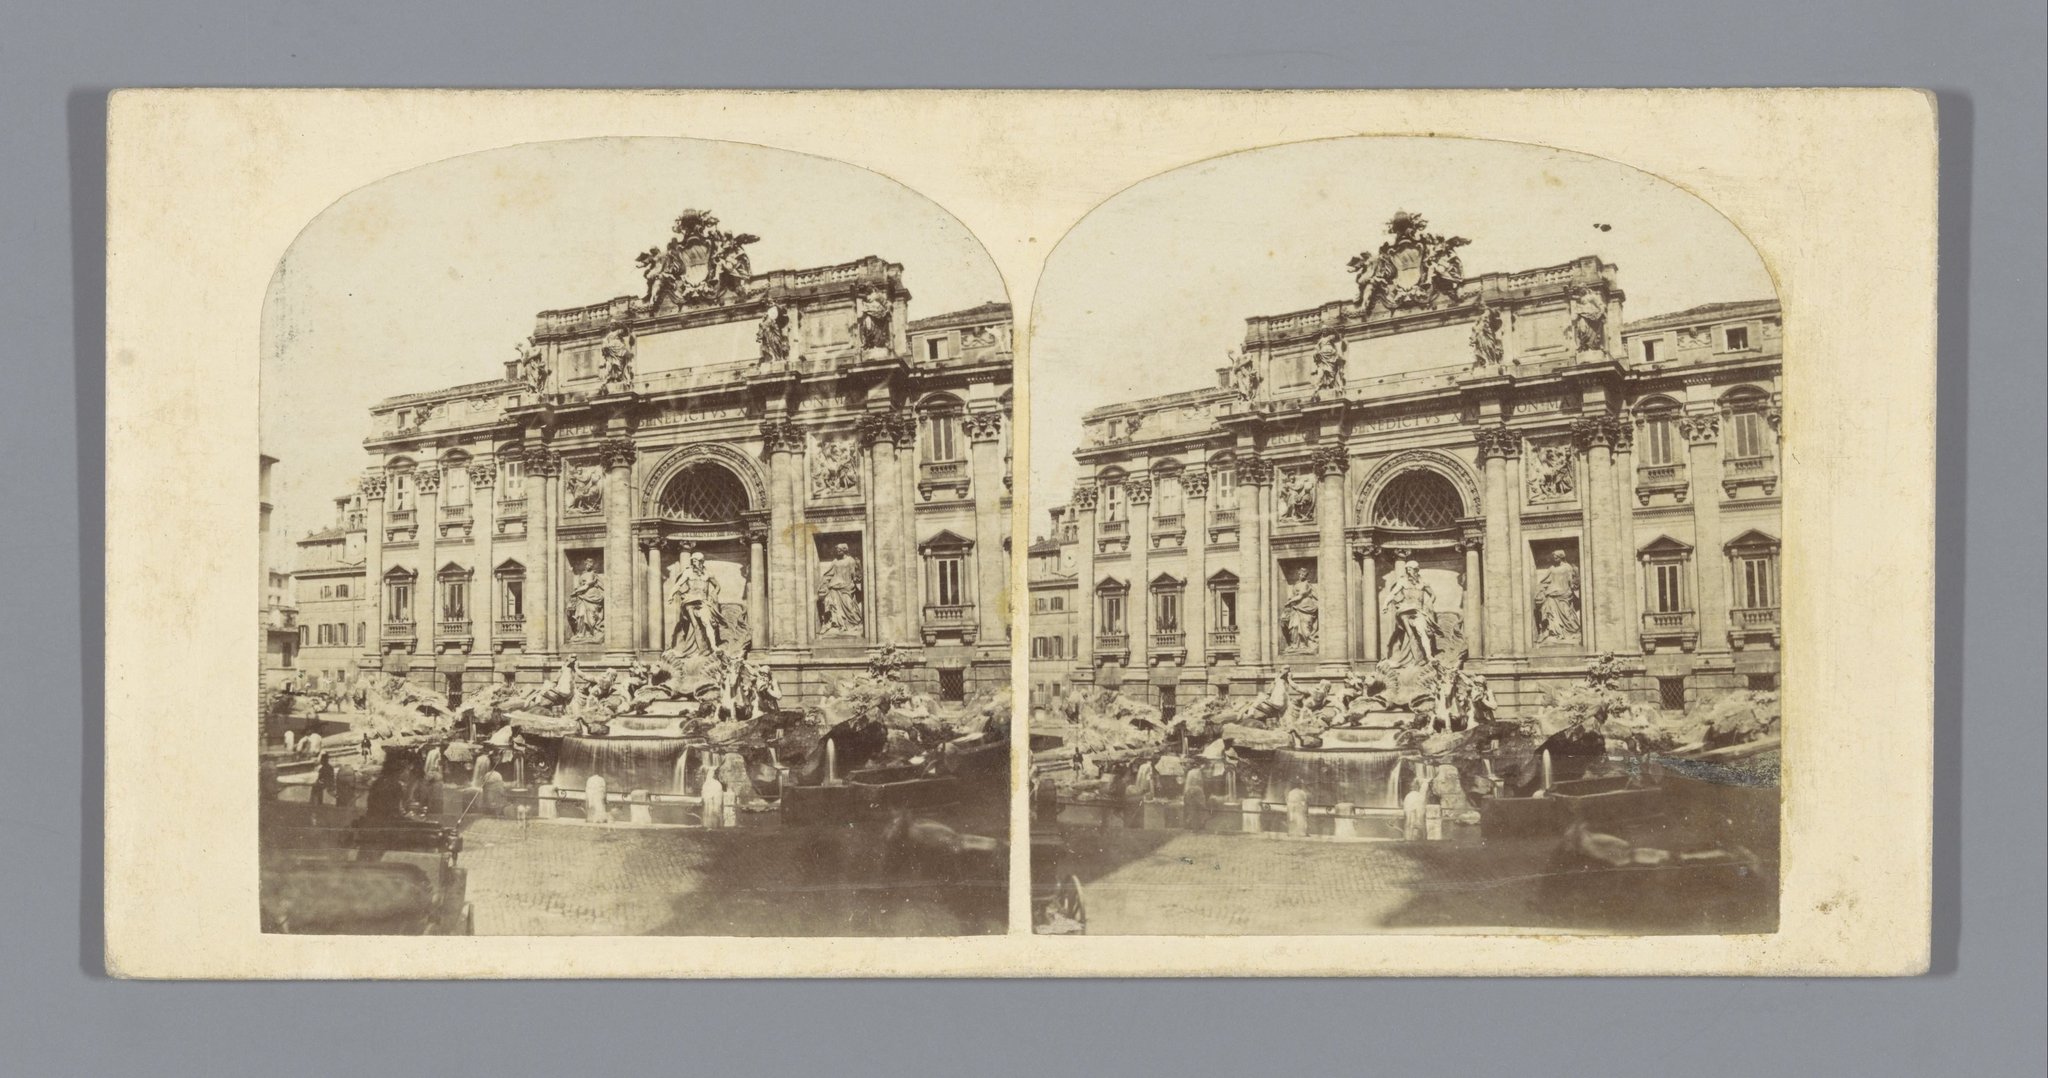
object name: stereograph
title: ROME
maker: Anonymous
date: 1850-1880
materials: cardboard, photographic support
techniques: albumen print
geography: rome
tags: ornamental fountain, sculpture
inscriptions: name: ‘Kunsthandlung Joh. Heinrigs zu CÖLN Hochstrasse 152. Liefert alle im In. und Auslande erschienenen Kunstblätter.’, inscription: ‘Fontaine Trevi’